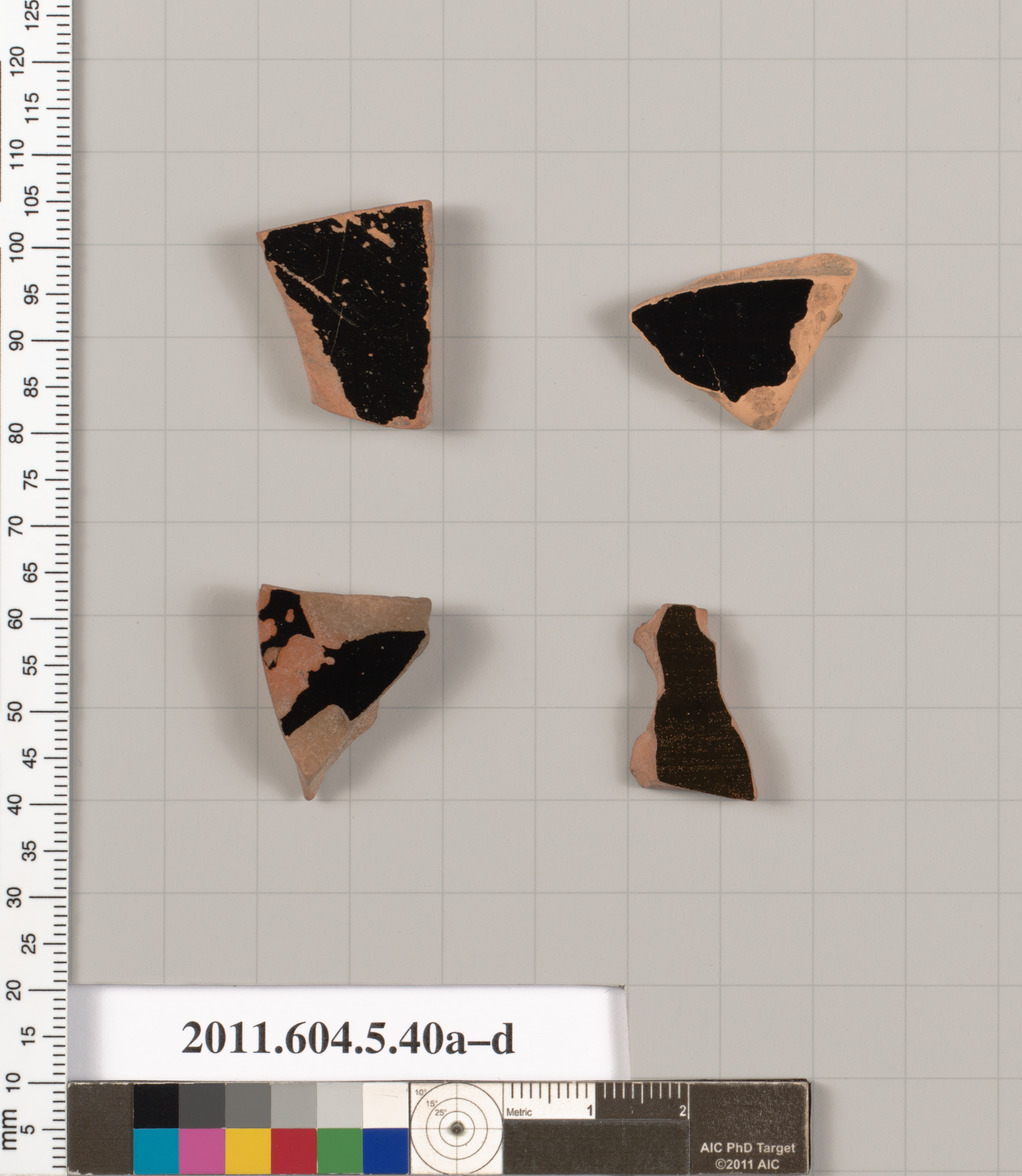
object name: kylix fragment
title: Terracotta fragments of kylikes (drinking cups)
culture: greek, attic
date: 500-480 BCE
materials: terracotta